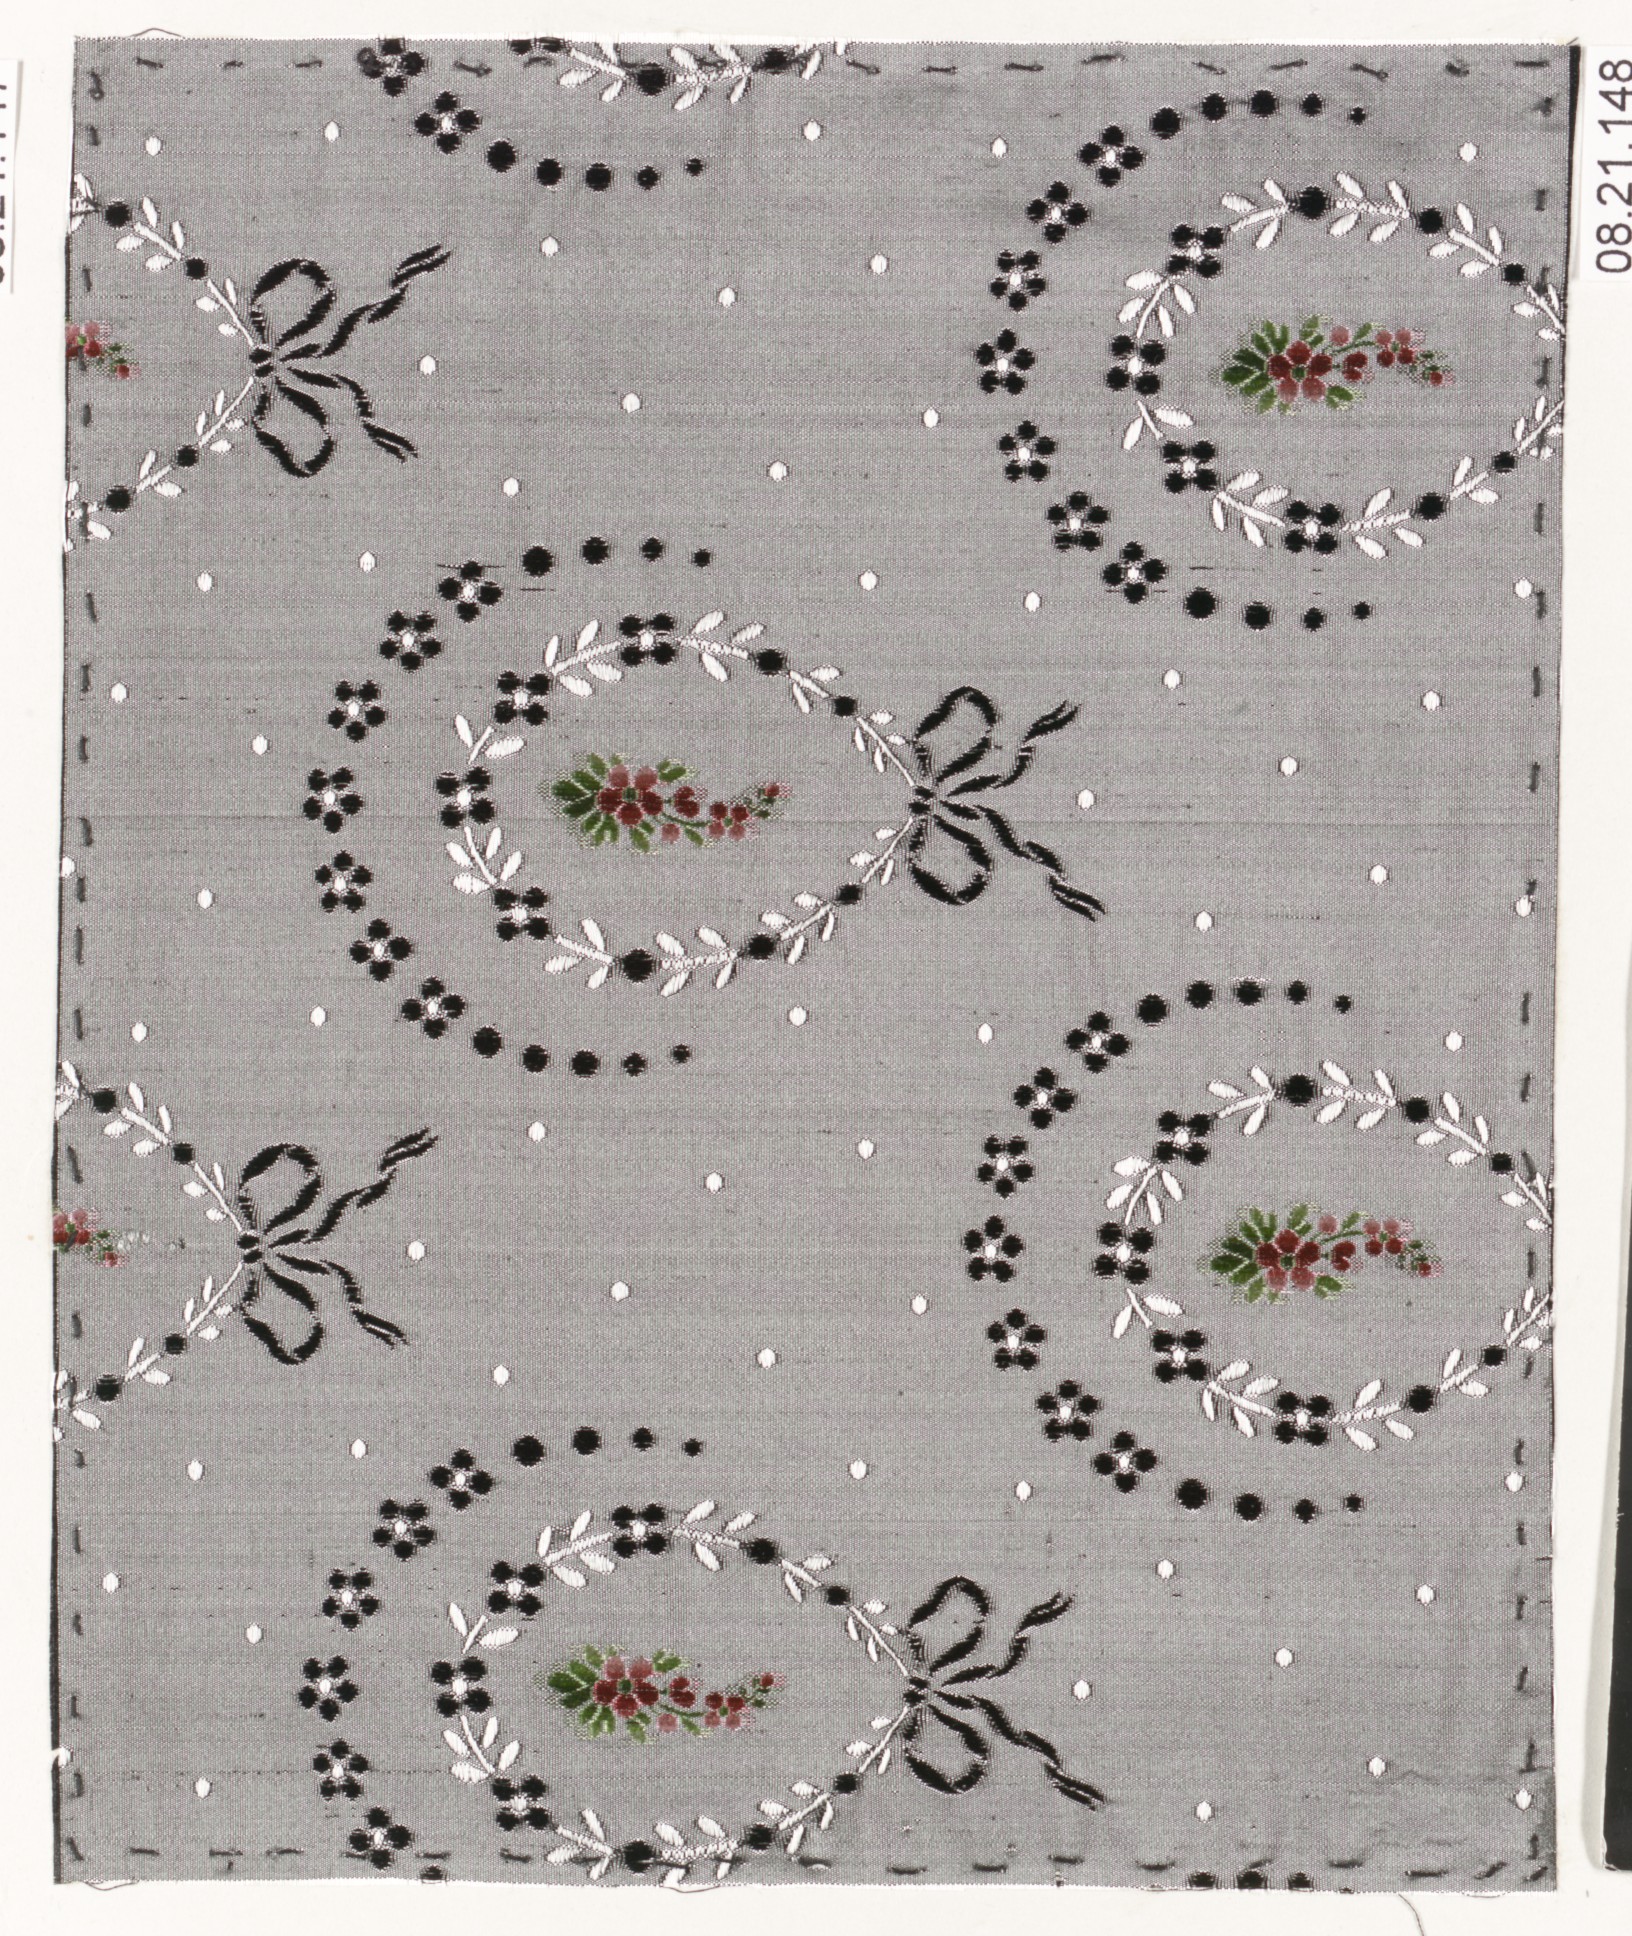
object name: textile sample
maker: Anonymous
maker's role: designer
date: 1900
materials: silk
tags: flowers